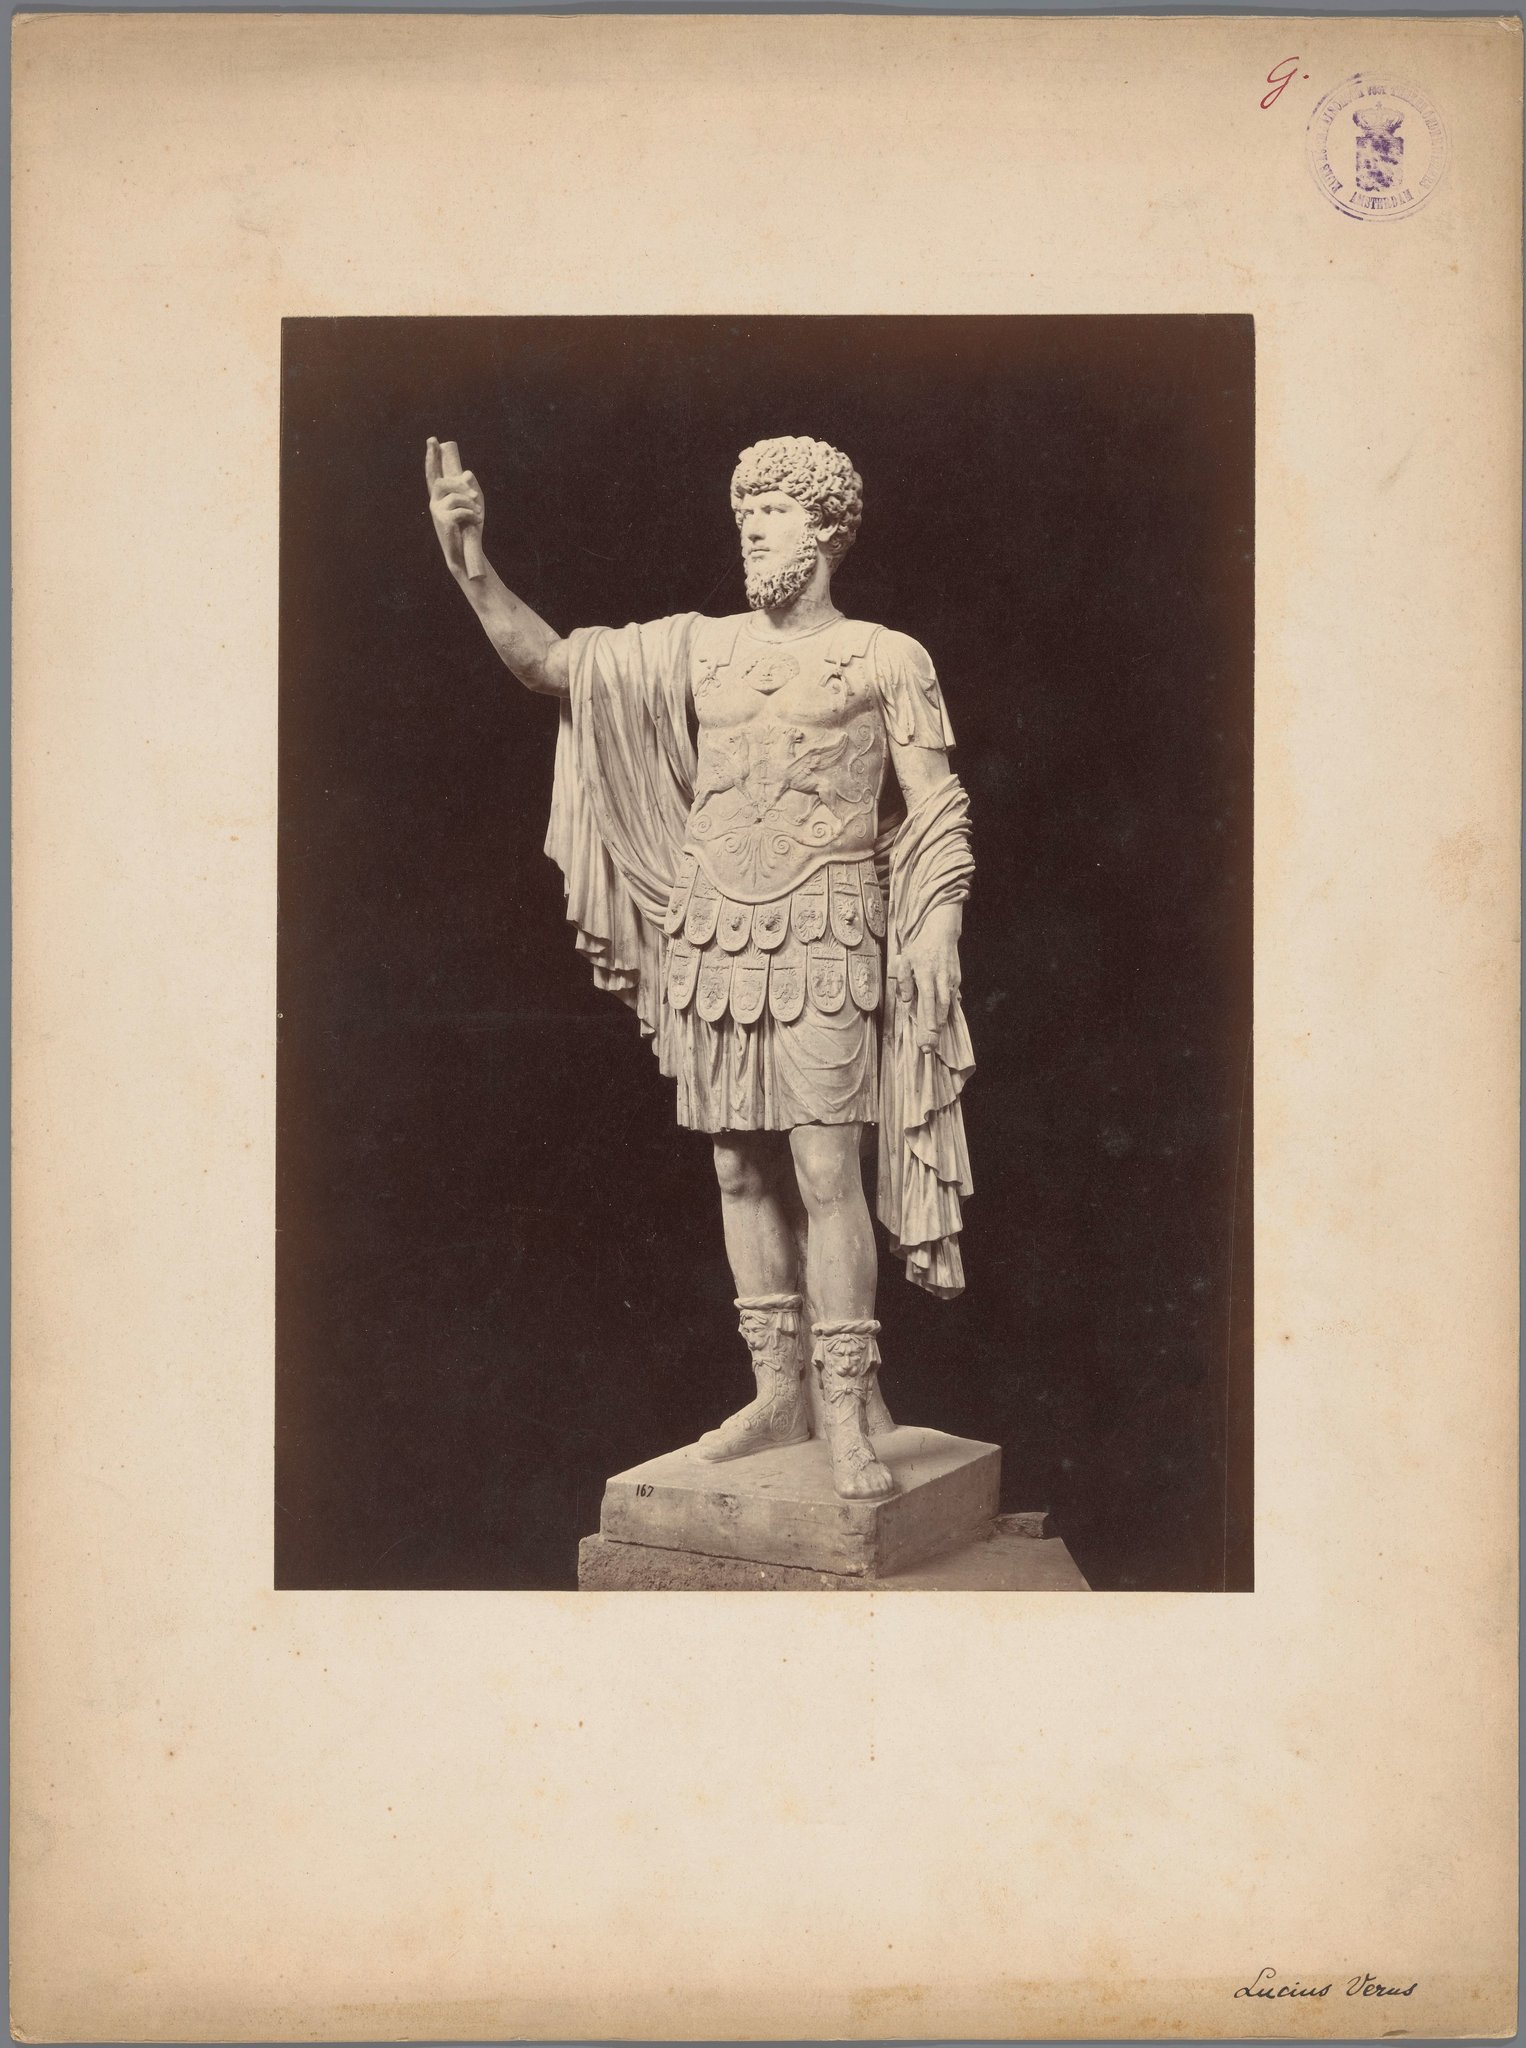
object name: photograph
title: Beeld van Lucius Verus te Napels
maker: Anonymous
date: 1850-1900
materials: cardboard, photographic support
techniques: albumen print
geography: naples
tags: emperor, sculpture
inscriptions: collector's mark: ‘Rijks normaalschool voor teekenonderwijzers Amsterdam’, inscription: ‘G.’, inscription: ‘Lucius Verus’